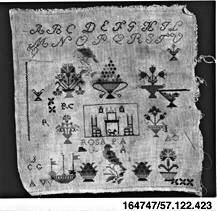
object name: sampler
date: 1801-1900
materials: canvas, cotton, silk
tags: birds,flowers